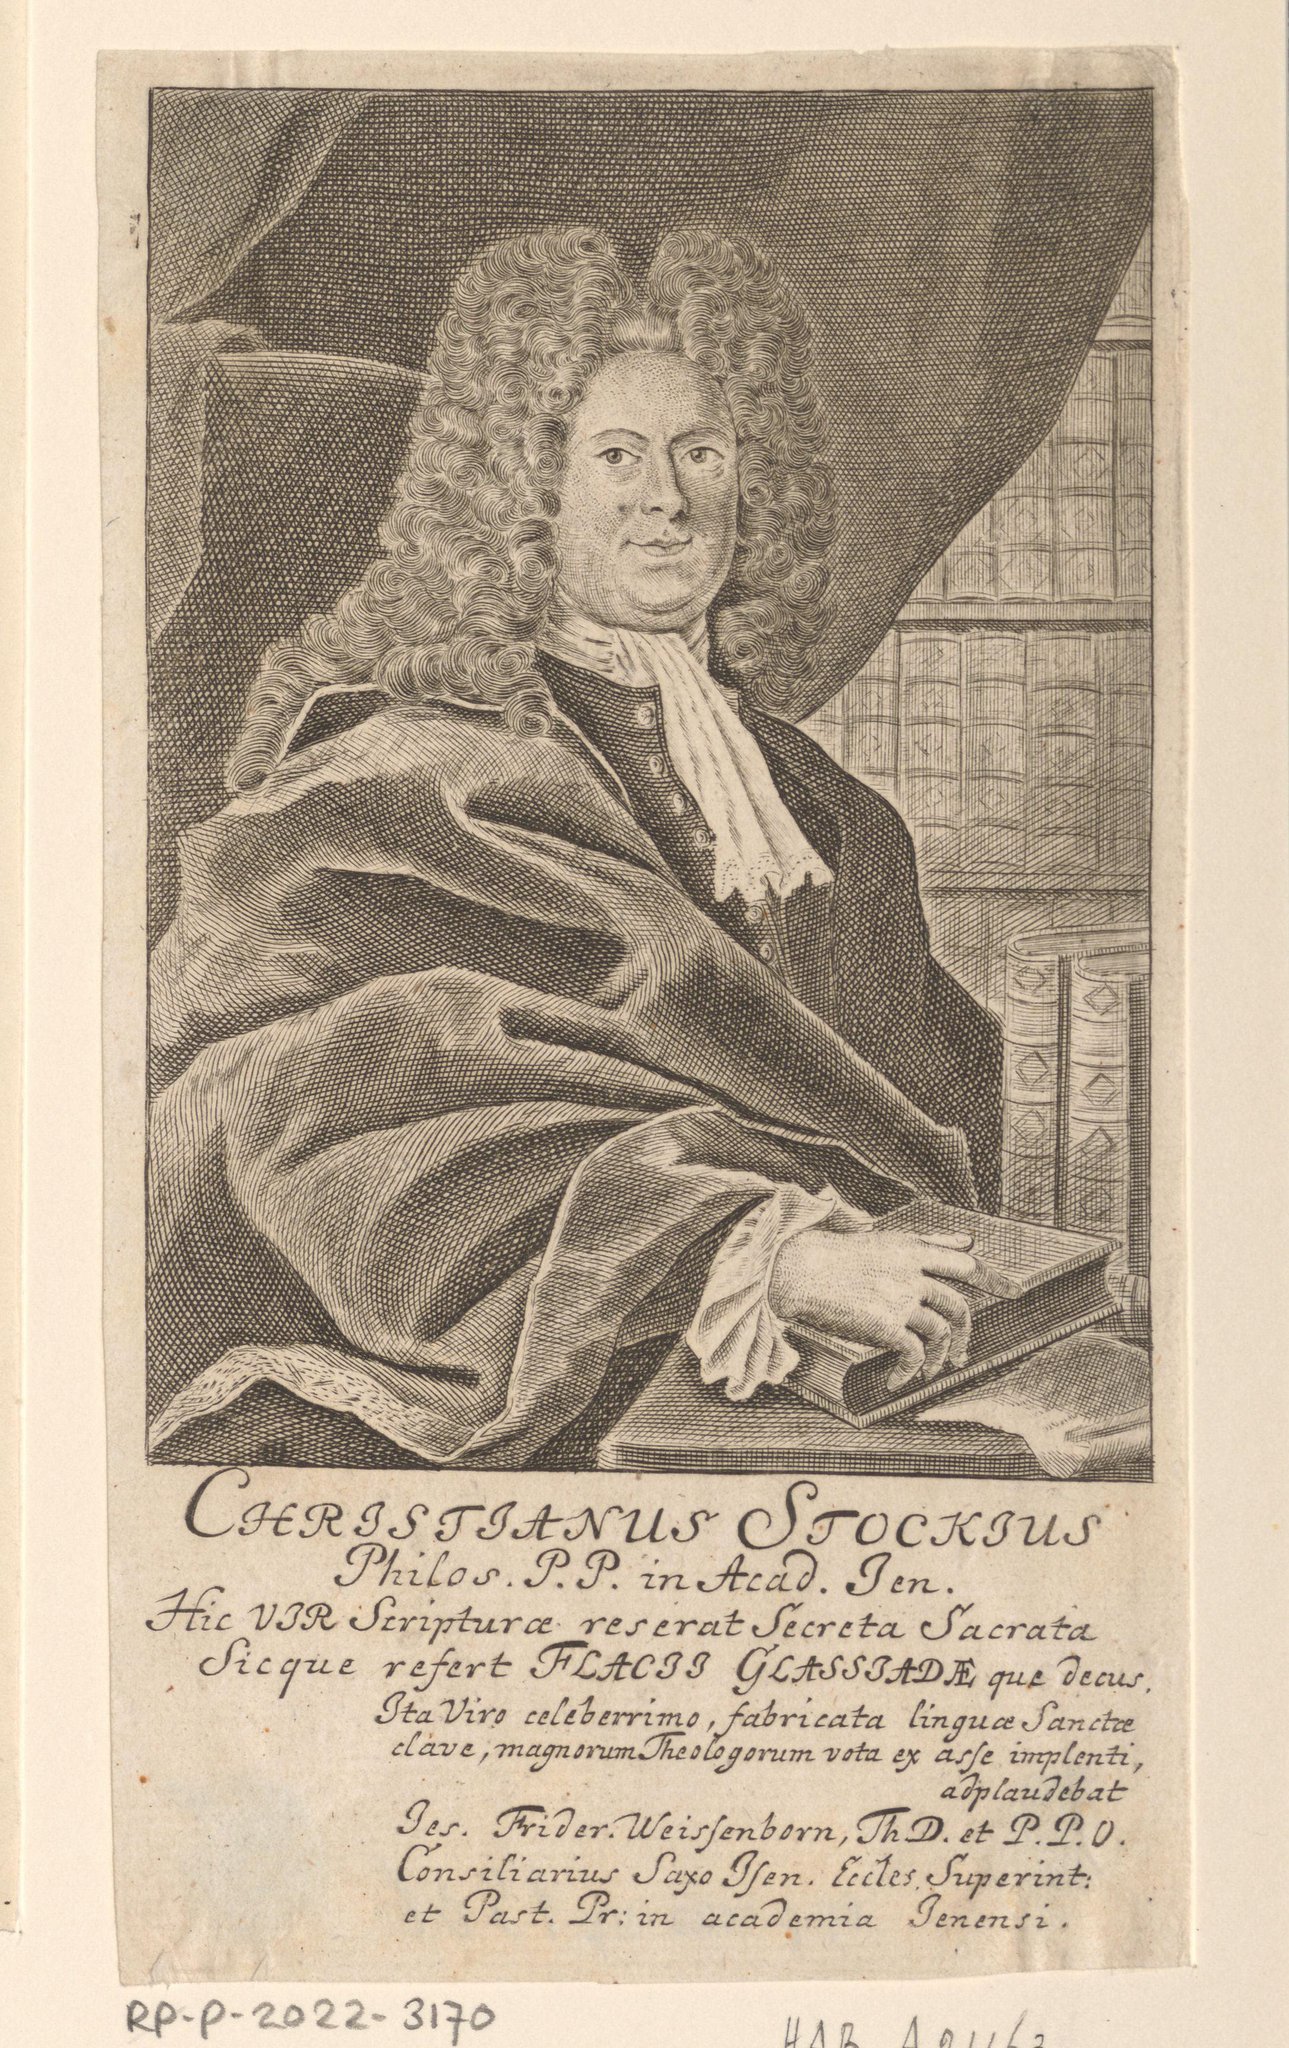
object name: print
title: Portret van Christian Stock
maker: martin bernigeroth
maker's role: print maker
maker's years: 1670-1733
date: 1692-1733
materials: paper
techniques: engraving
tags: christian stock, historical persons, professor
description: Met negenregelig onderschrift in het Latijn.